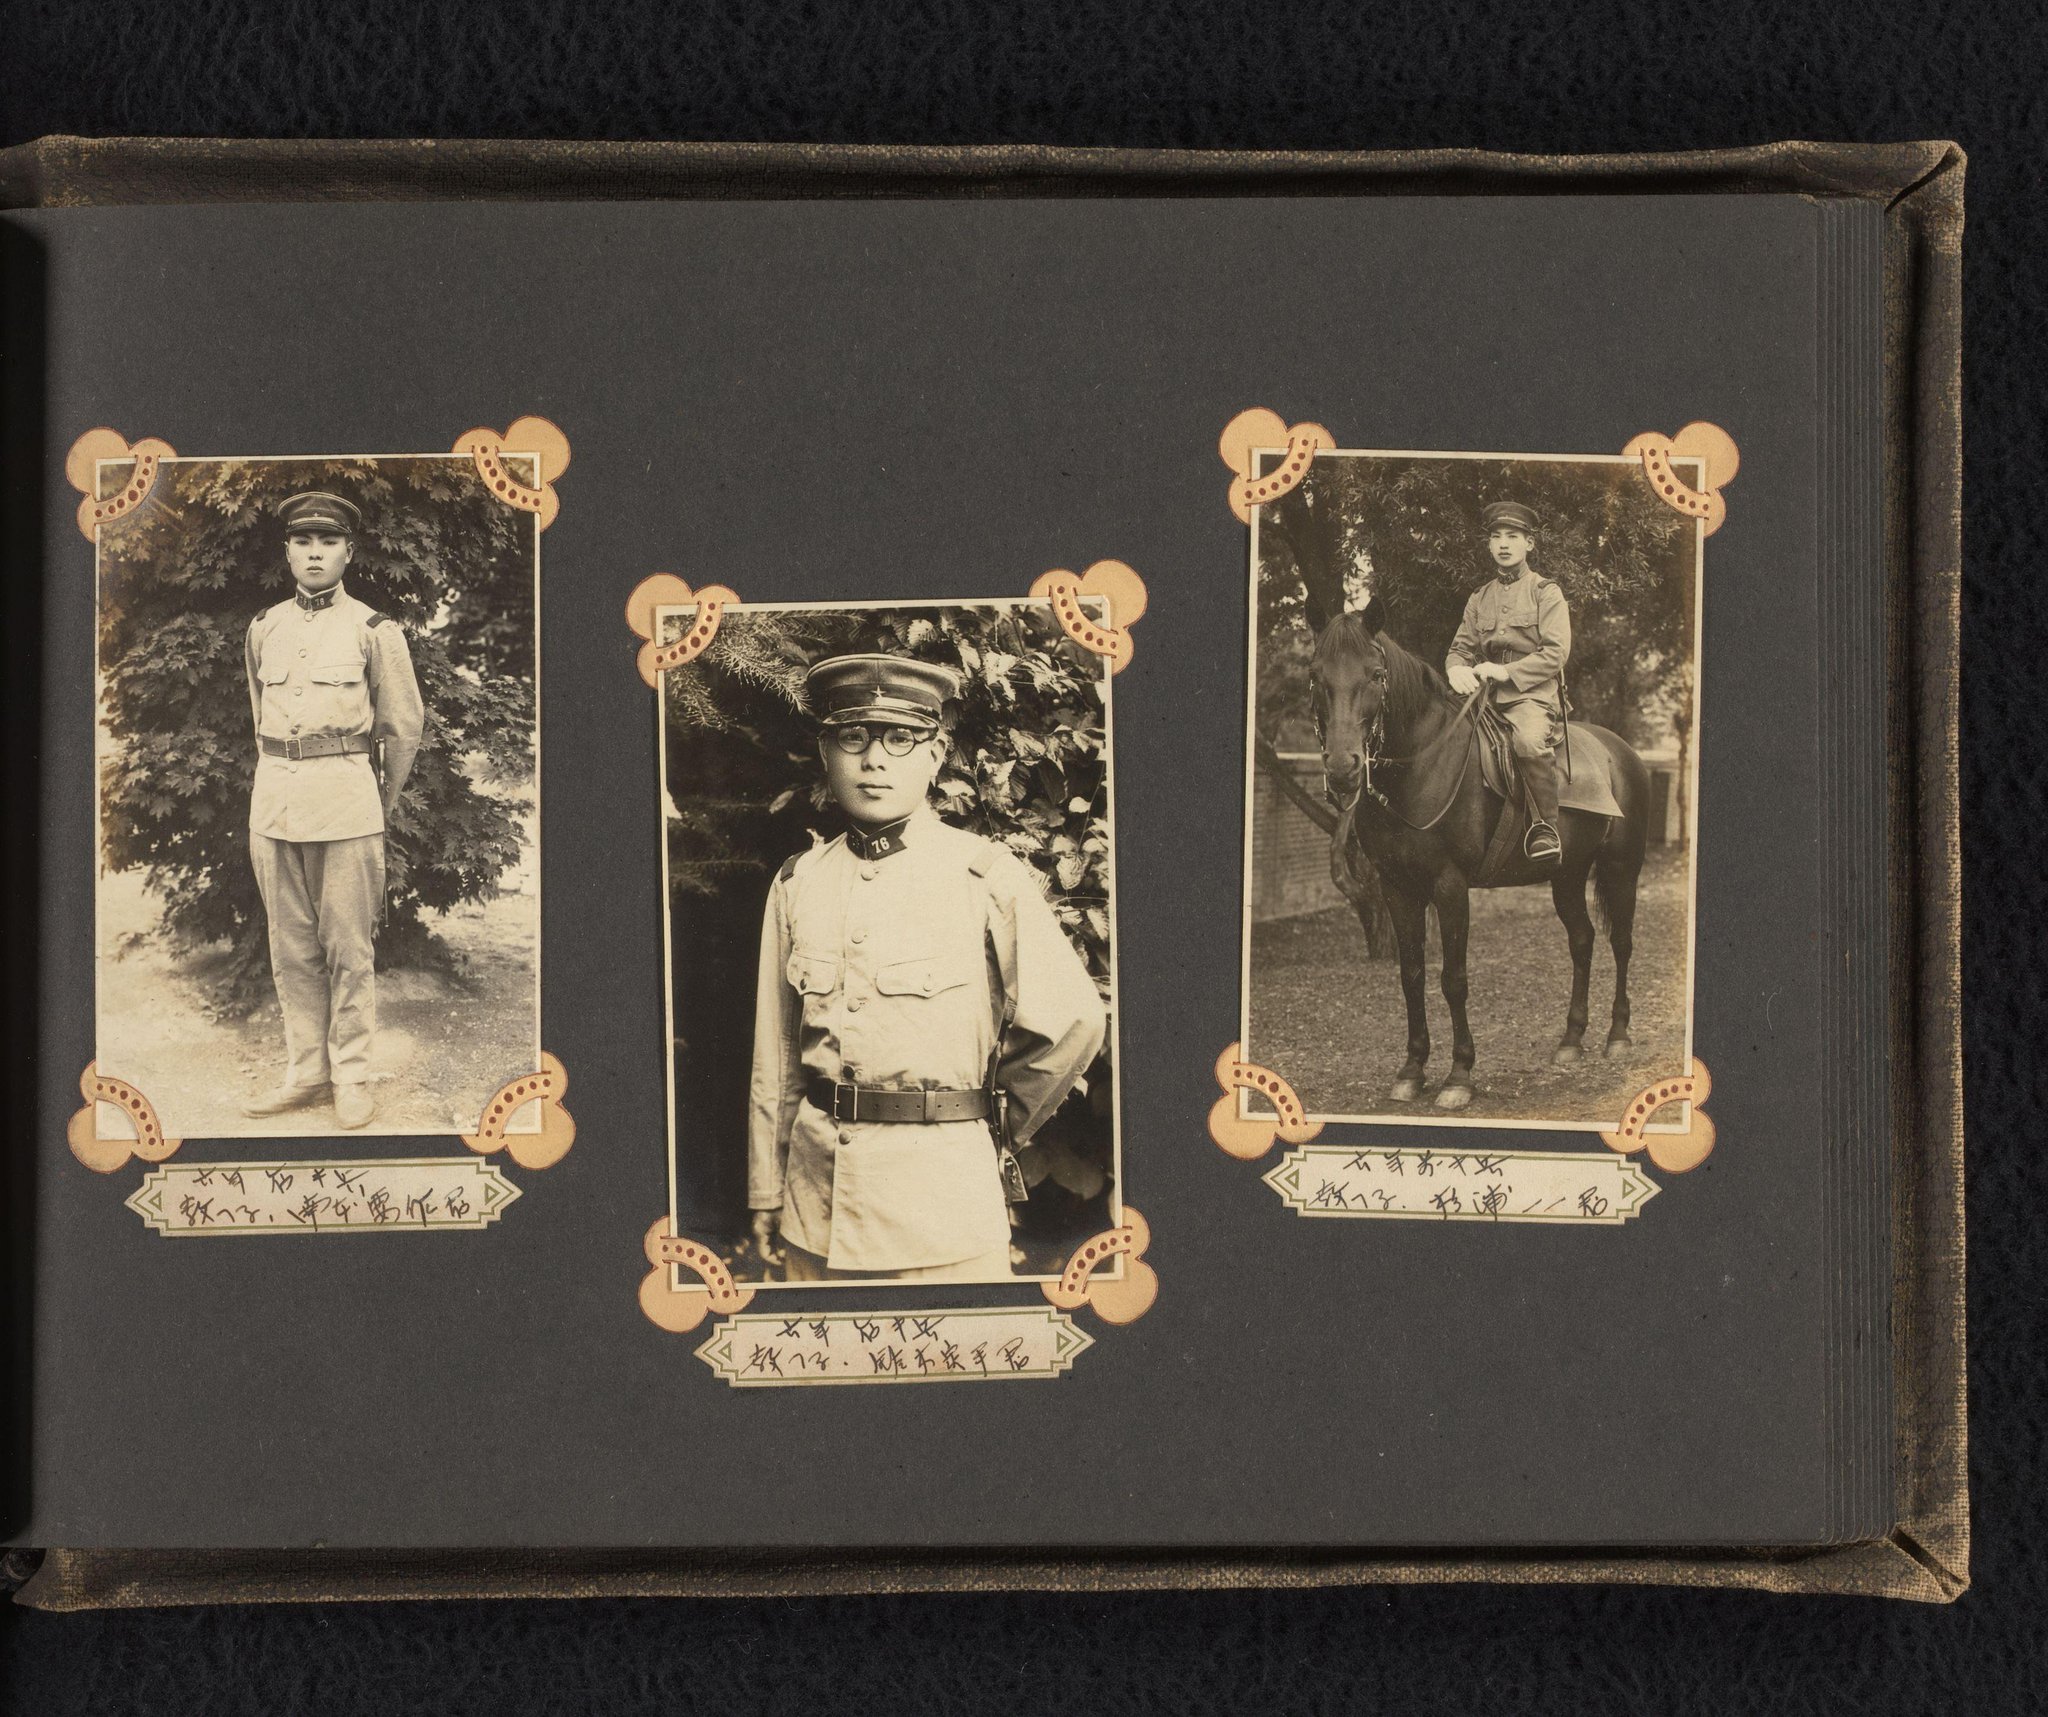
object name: album leaf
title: Drie portretten van onbekende Japanse soldaten, een te paard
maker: Anonymous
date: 1930-1940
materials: paper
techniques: gelatin silver print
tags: anonymous historical person portrayed, the soldier; the soldier's life, horse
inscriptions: inscription: ‘[...]’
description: Deze foto's zijn onderdeel van een album.